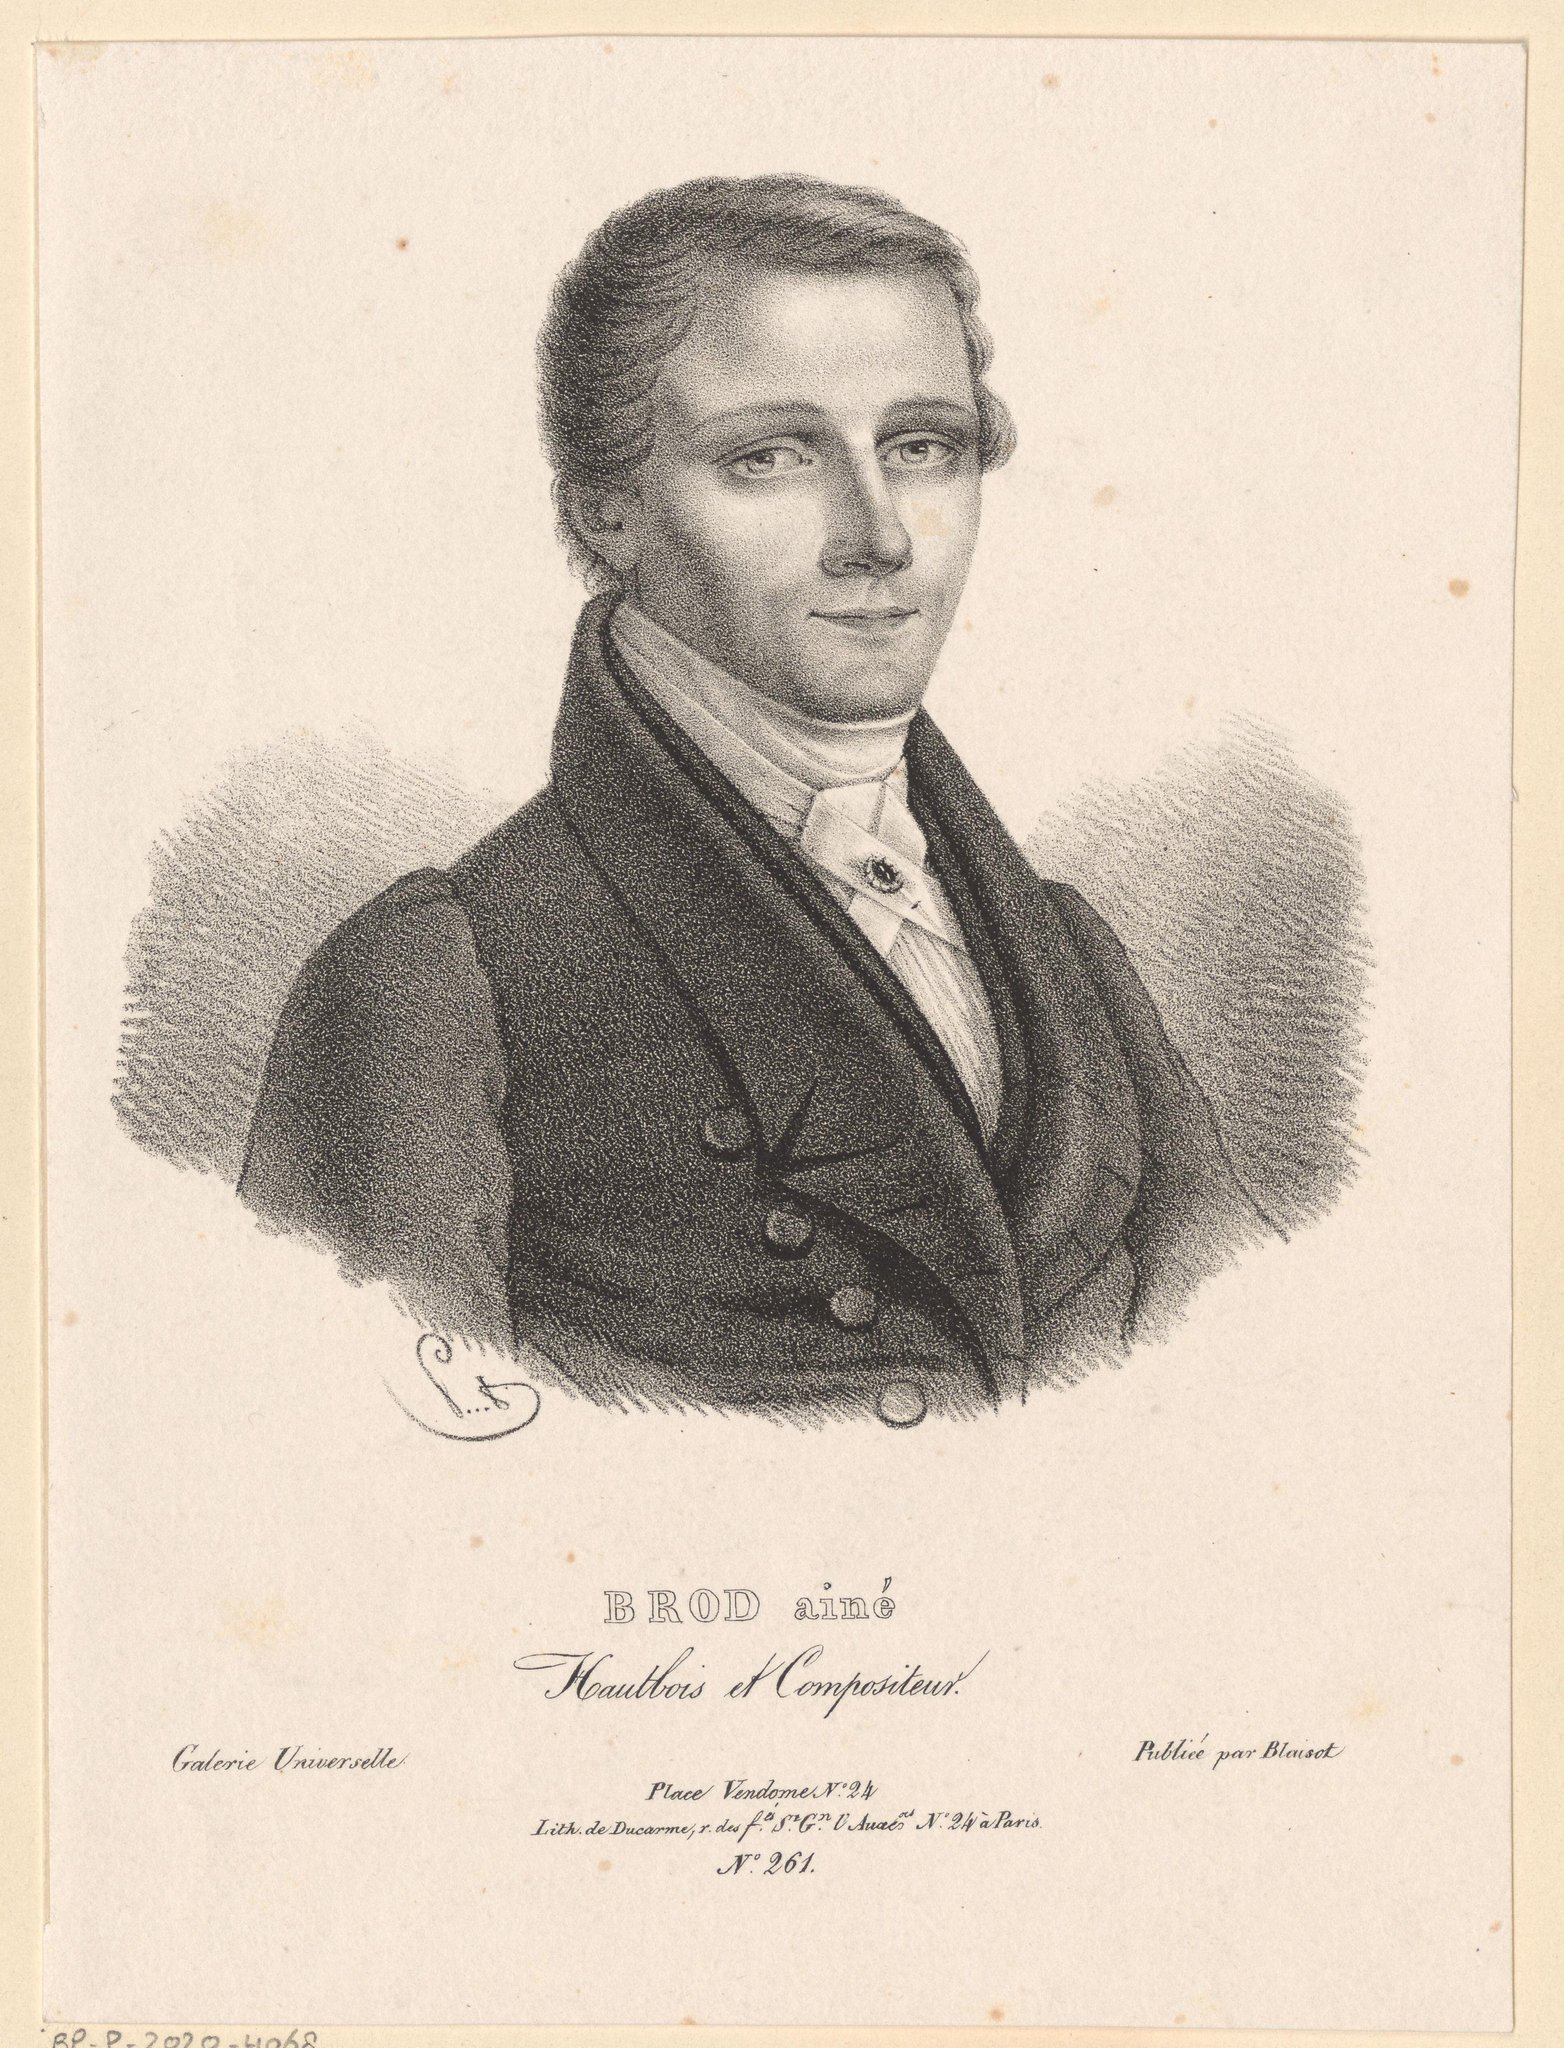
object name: print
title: Portret van Henri Brod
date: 1835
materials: paper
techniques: lithograph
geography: paris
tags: musical instrument maker, henri brod, historical persons, portrait of a musician, portrait of composer